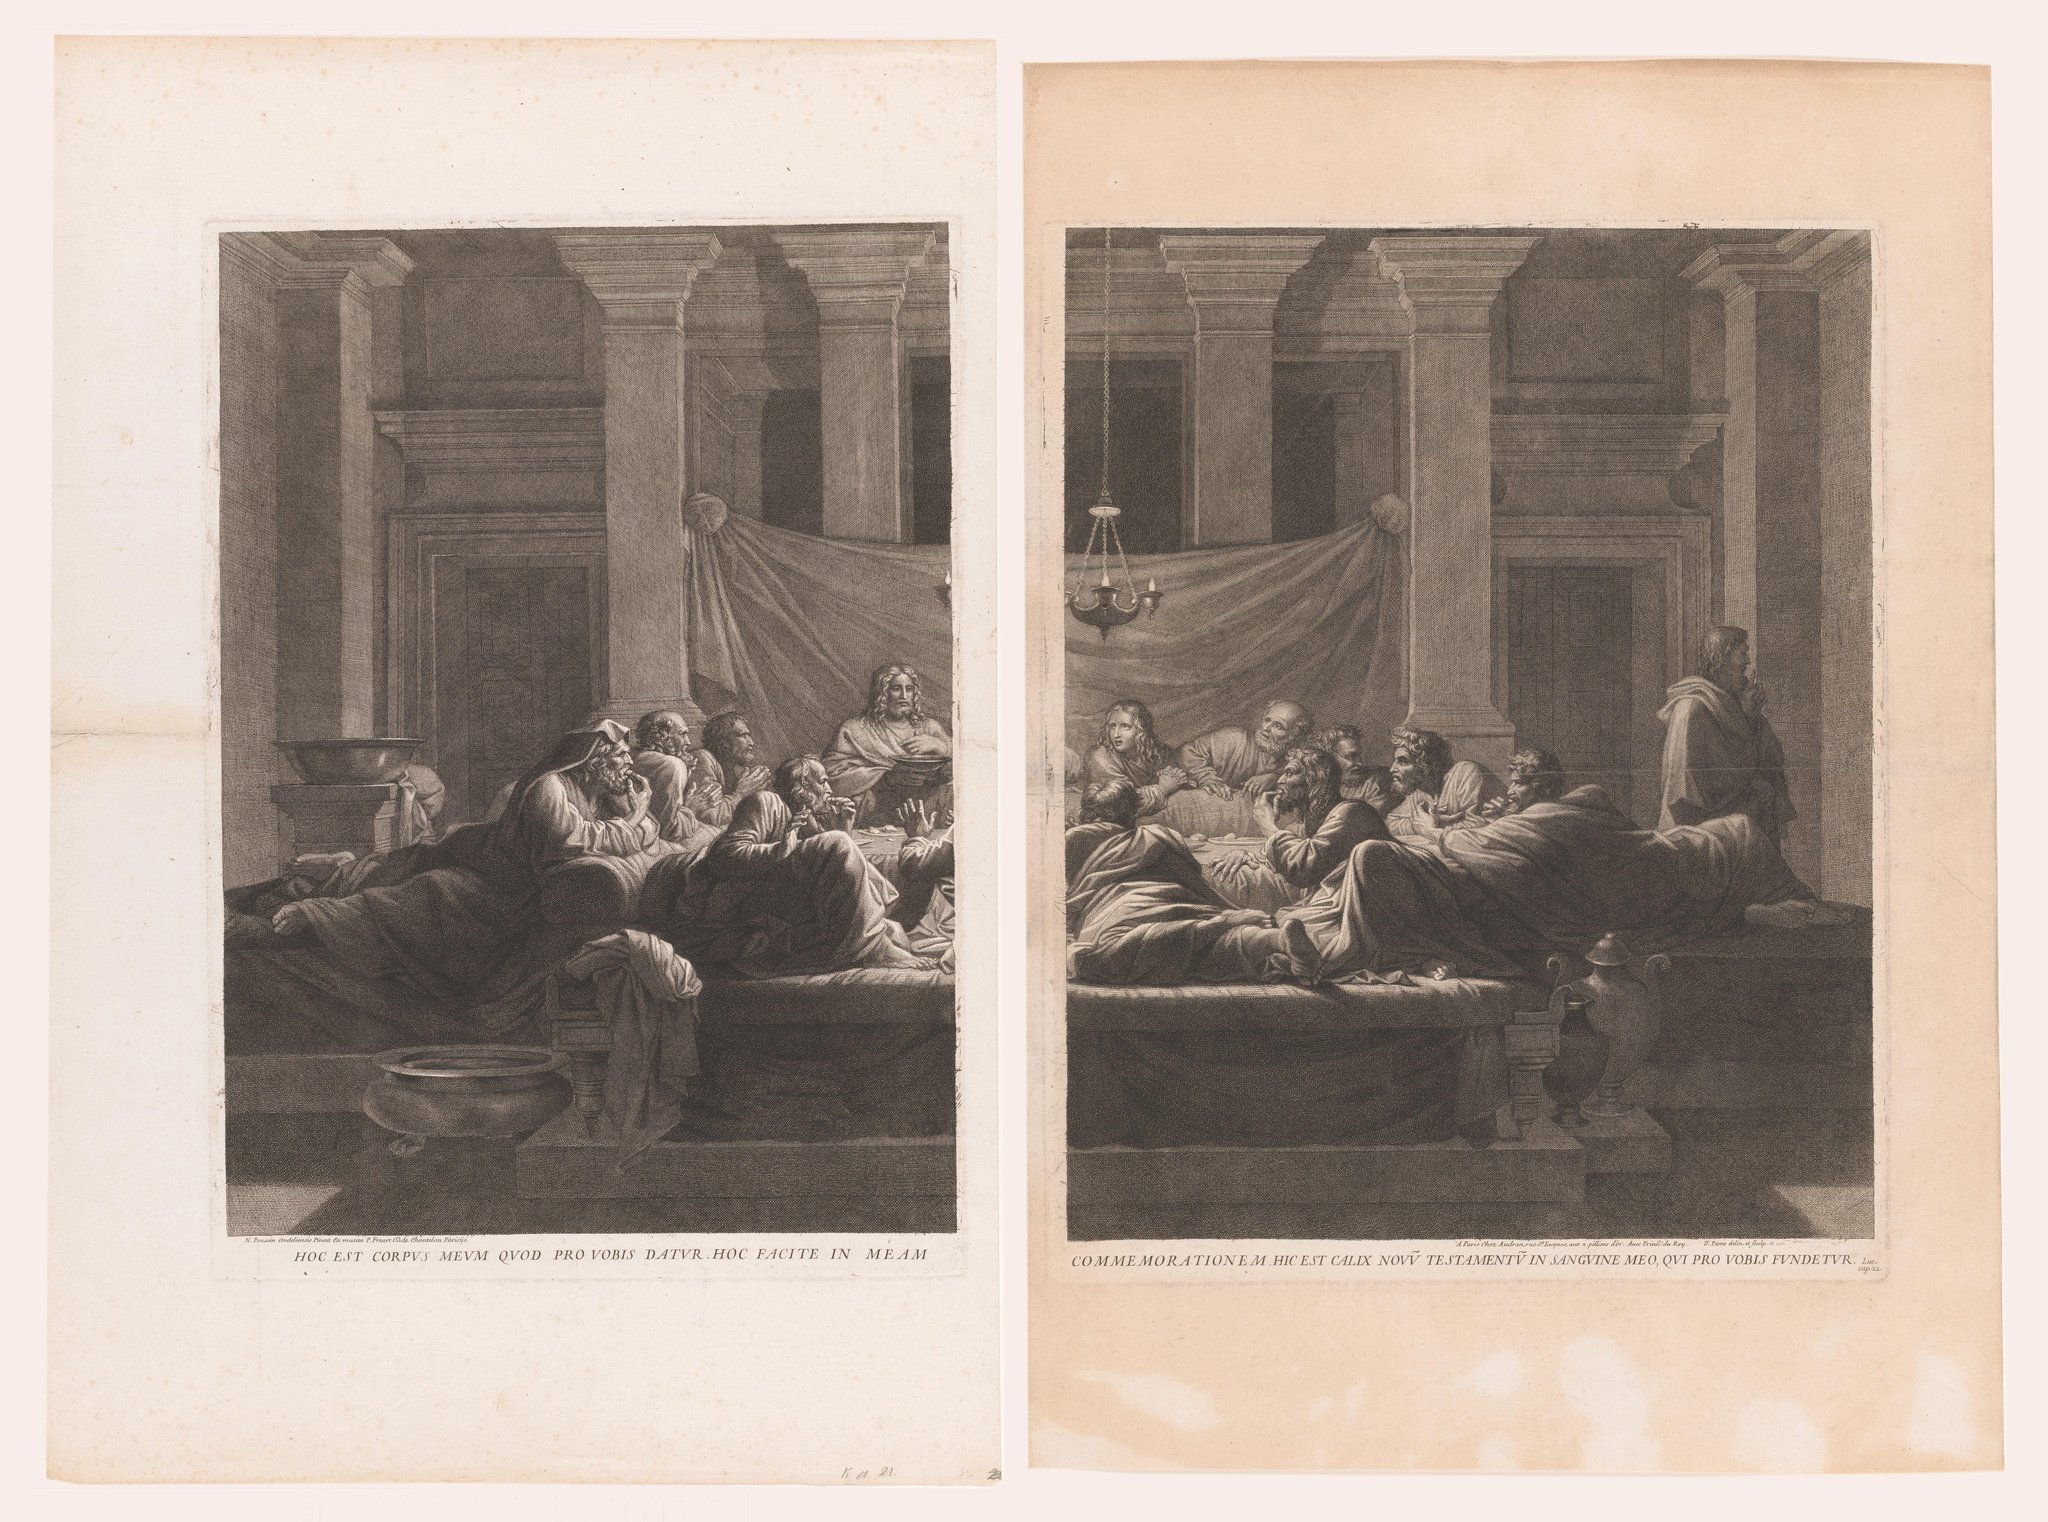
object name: print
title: Hoc est meum quod pro vobis datur (...) vobis fundetur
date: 1680-1694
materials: paper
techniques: etching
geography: paris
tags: the eucharist ~ the fourth of the seven sacraments, institution of the eucharist, i.e. christ showing or blessing bread (host) and/or wine (matthew 26:26-27; mark 14:22-23; luke 22:19-20; john 13:26; 1 corinthians 11:23-25)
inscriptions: collector's mark: Lugt 240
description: Prent maakt deel uit van een ongenummerde serie van zeven prenten. Dit object is omwille van een betere presentatie virtueel samengevoegd, maar bestaat fysiek uit losse onderdelen.